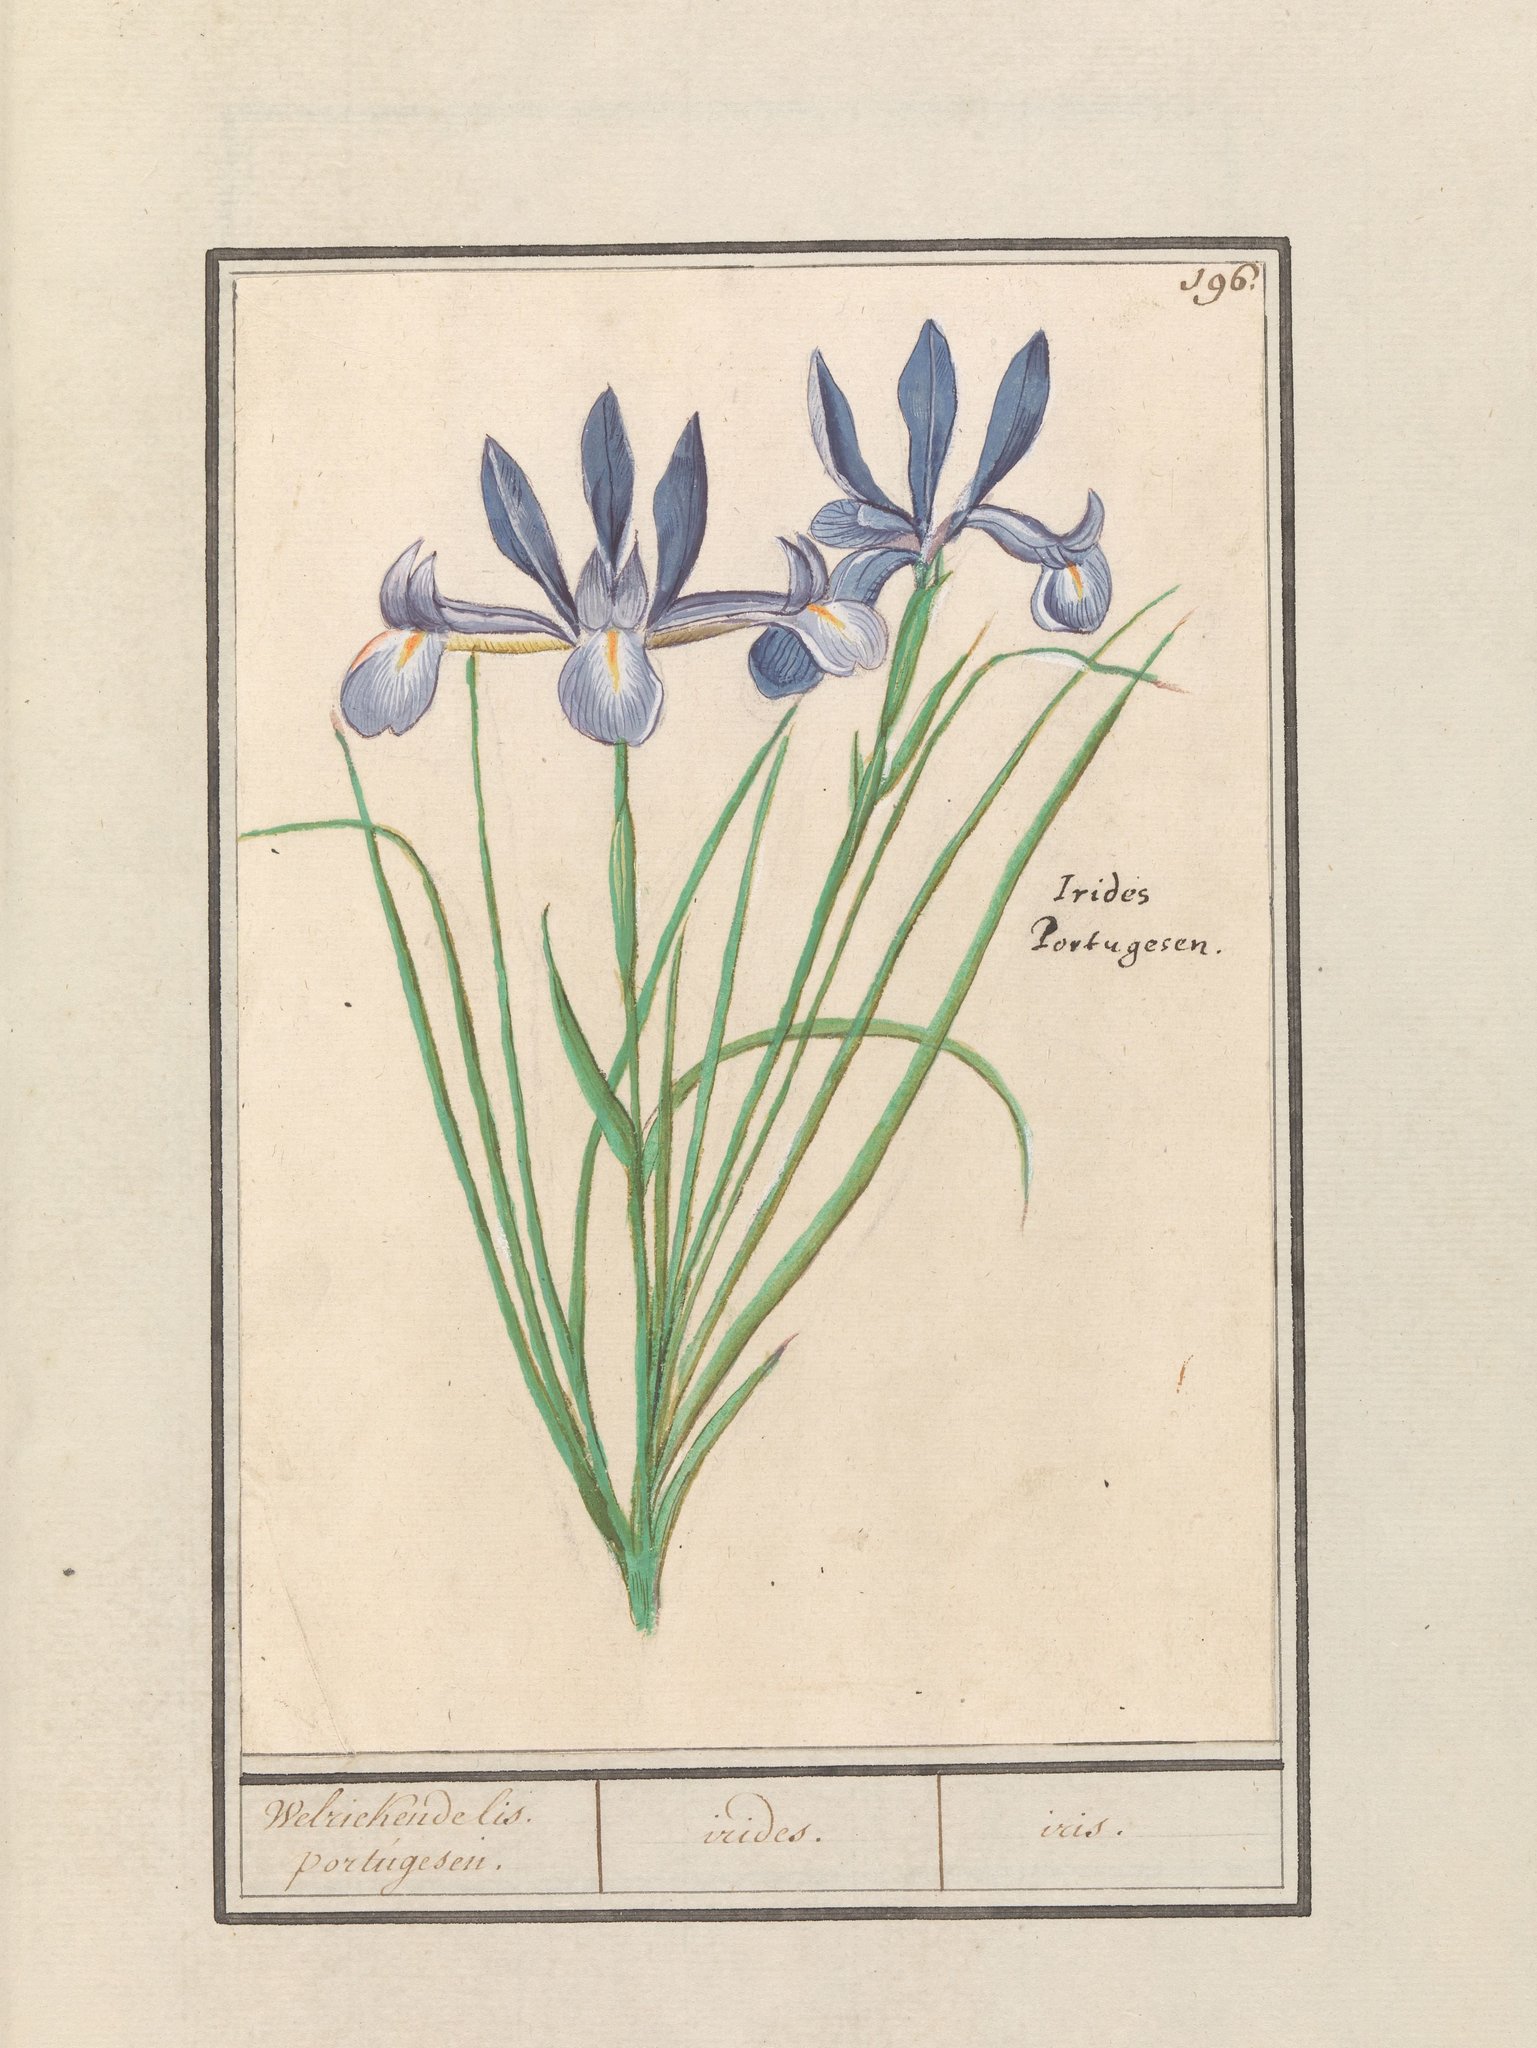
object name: drawing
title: Blauwe lis (Iris sibirica)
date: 1596-1610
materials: chalk, paint, ink, paper, watercolor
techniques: brush, pen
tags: flowers: iris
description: Blauwe lis. Genummerd rechtsboven: 196. Rechts de Latijnse naam. Onderdeel van het tweede album met tekeningen van bloemen en planten. Negende van twaalf albums met tekeningen van dieren, vogels en planten bekend rond 1600, gemaakt in opdracht van keizer Rudolf II. Met toelichting in Nederlands, Latijn en Frans.